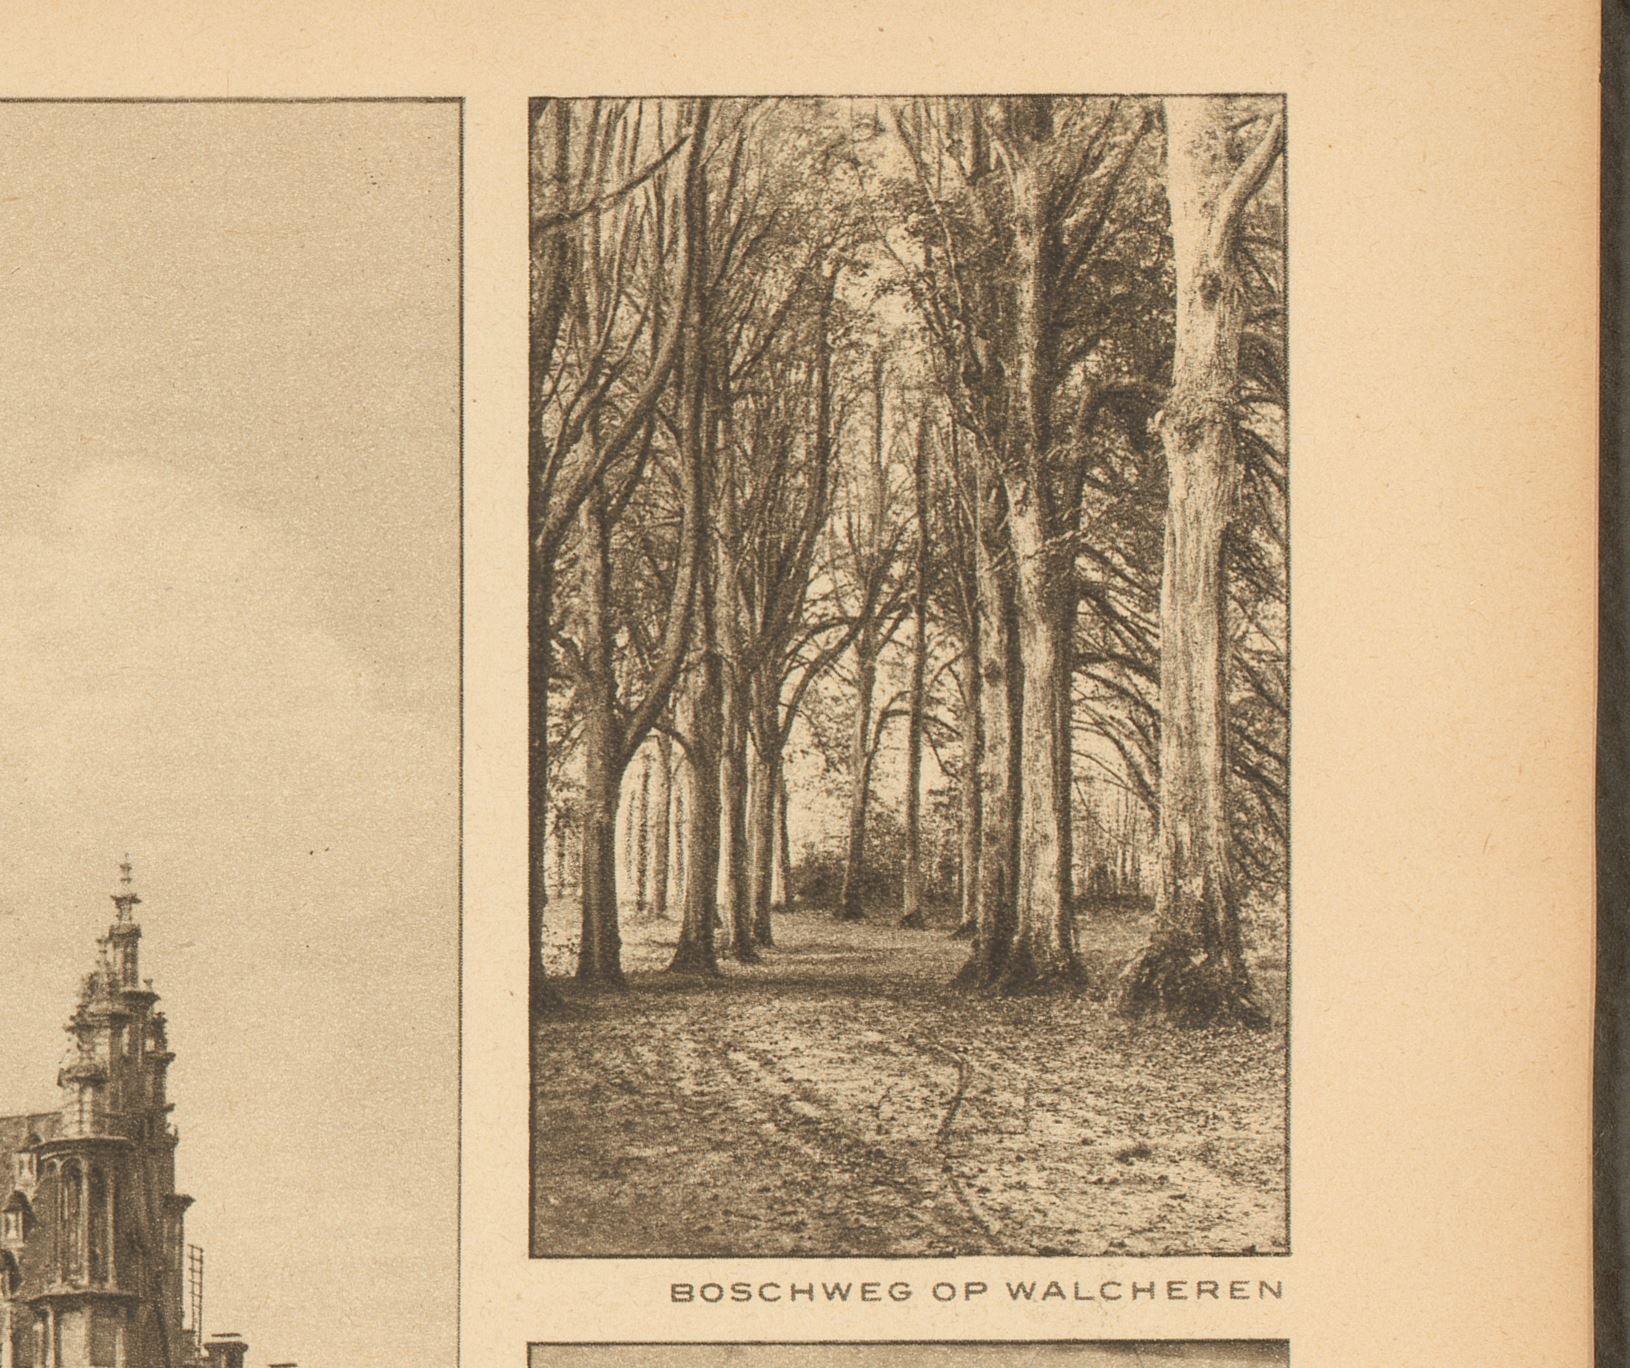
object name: album leaf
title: Gezicht op een bospad op Walcheren, Zeeland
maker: Anonymous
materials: paper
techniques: rotogravure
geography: leiden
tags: forest path or lane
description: Deze prent maakt deel uit van een album.